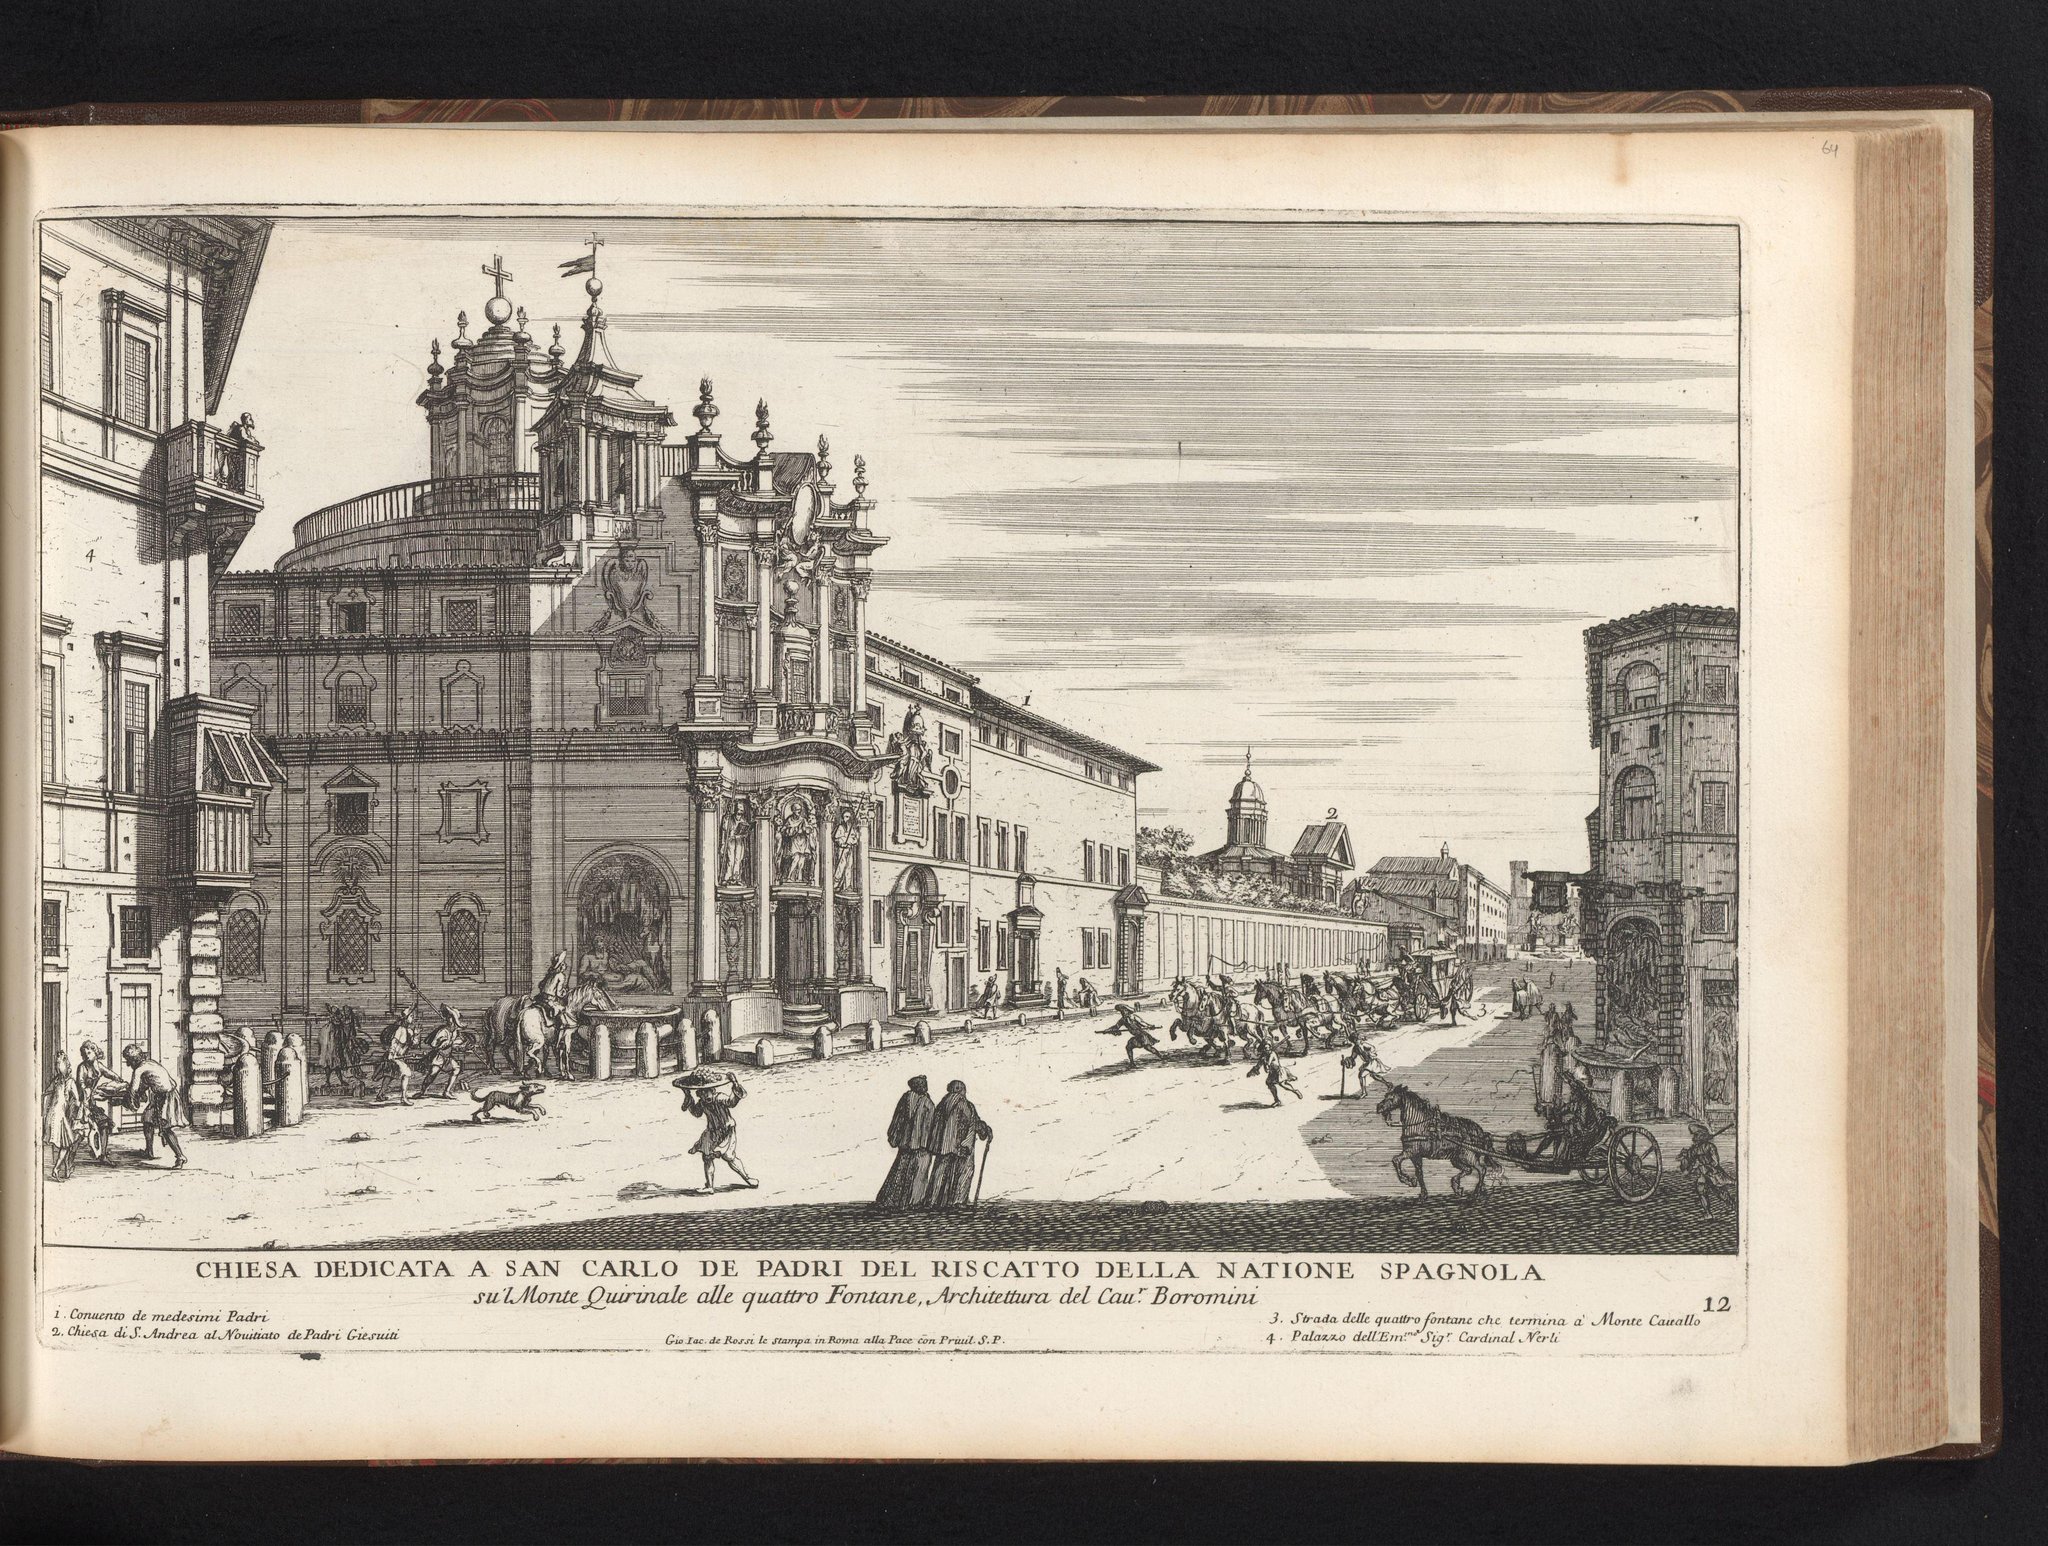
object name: print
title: Il nuovo teatro di Roma moderna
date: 1669-1670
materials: paper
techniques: etching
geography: vatican city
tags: city-view, and landscape with man-made constructions, church (exterior), ornamental fountain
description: Deze titelprent maakt deel uit van een reeks van 38 prenten met voorstellingen van kerken in Rome. Samen met vier andere reeksen vormt het de grote reeks: 'Il nuovo teatro di Roma moderna'.